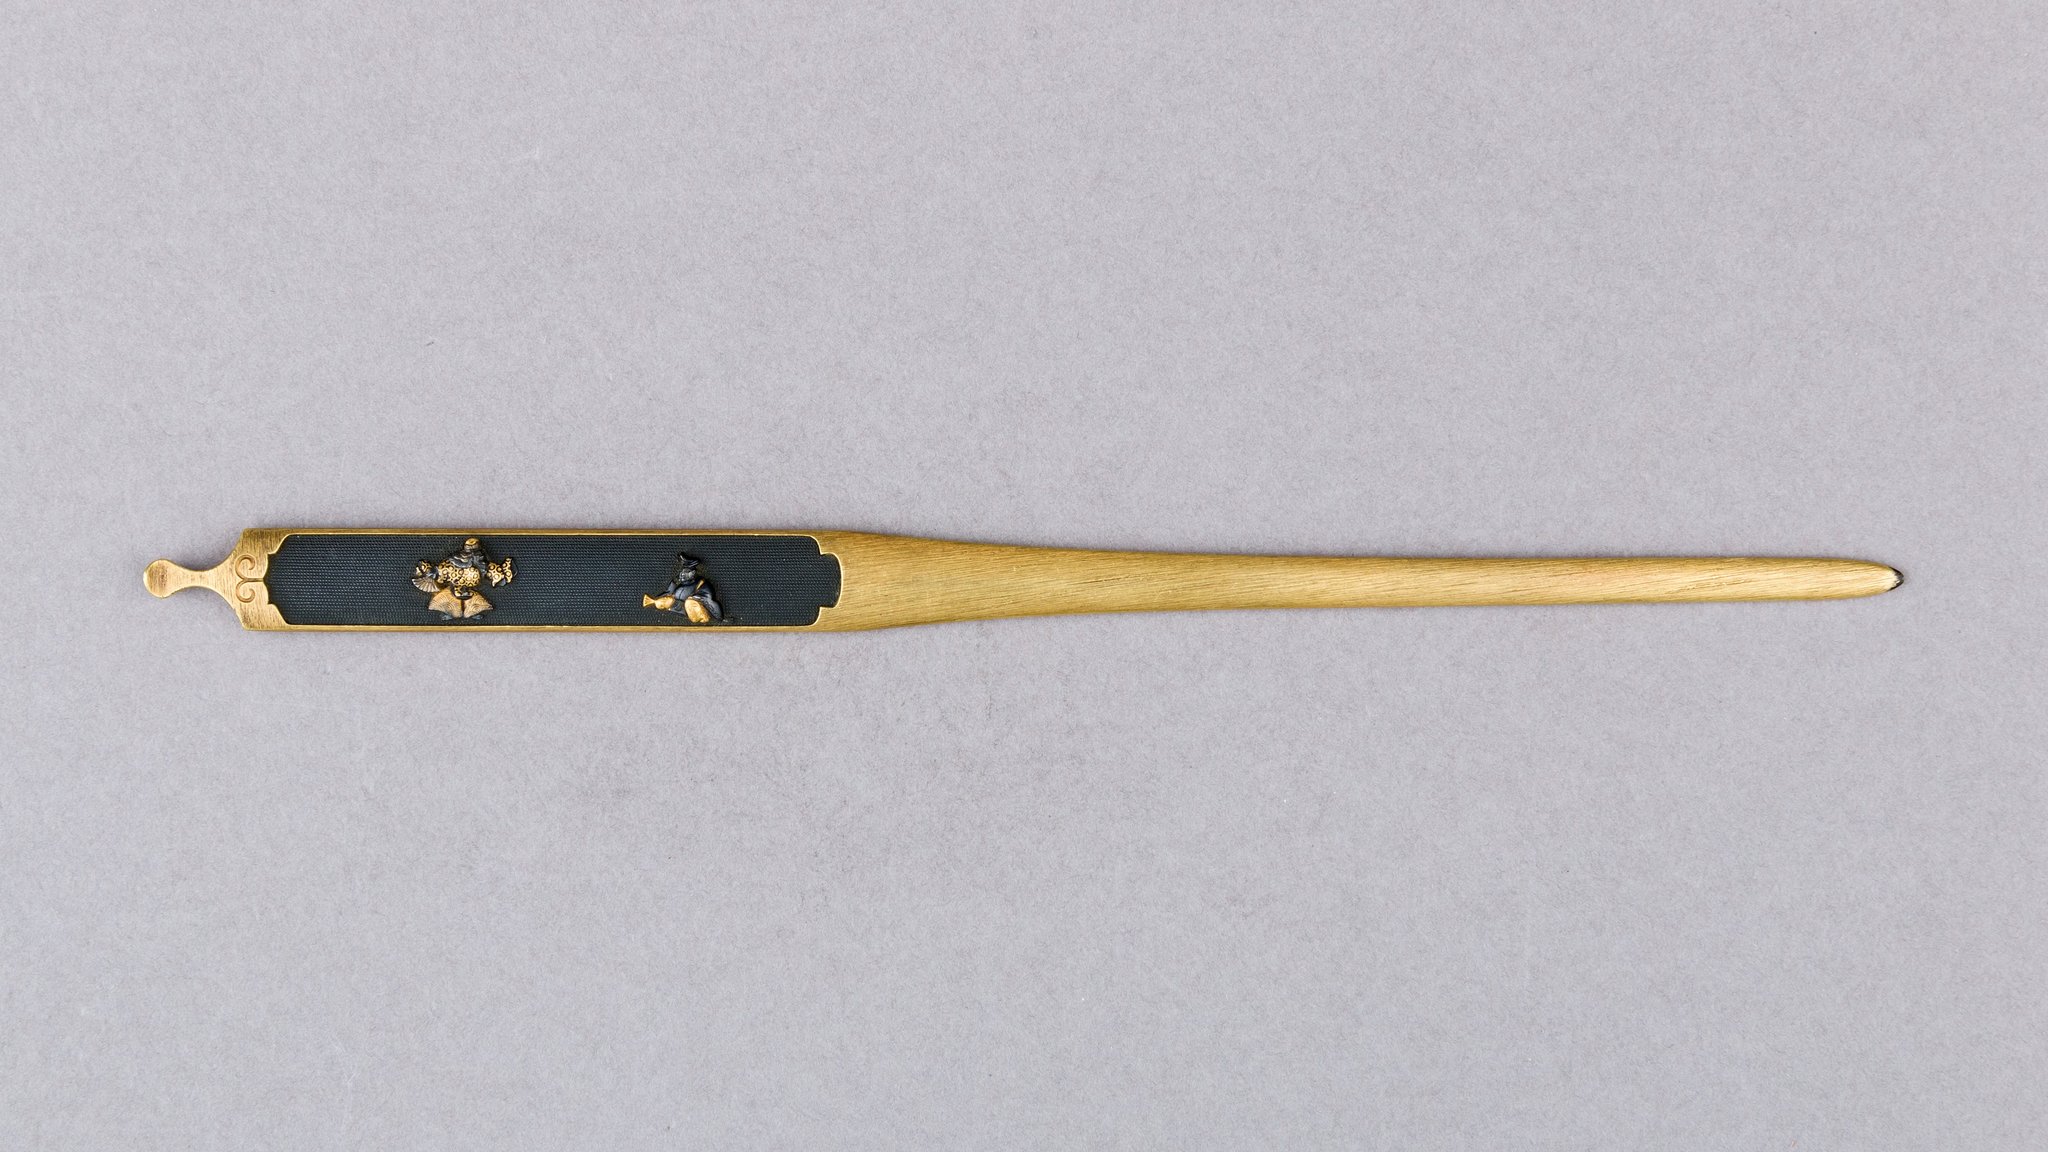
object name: hair dressing tool kogai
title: Hair Dressing Tool (Kogai)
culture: japanese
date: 1615-1868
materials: gold alloy, gold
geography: japan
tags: men